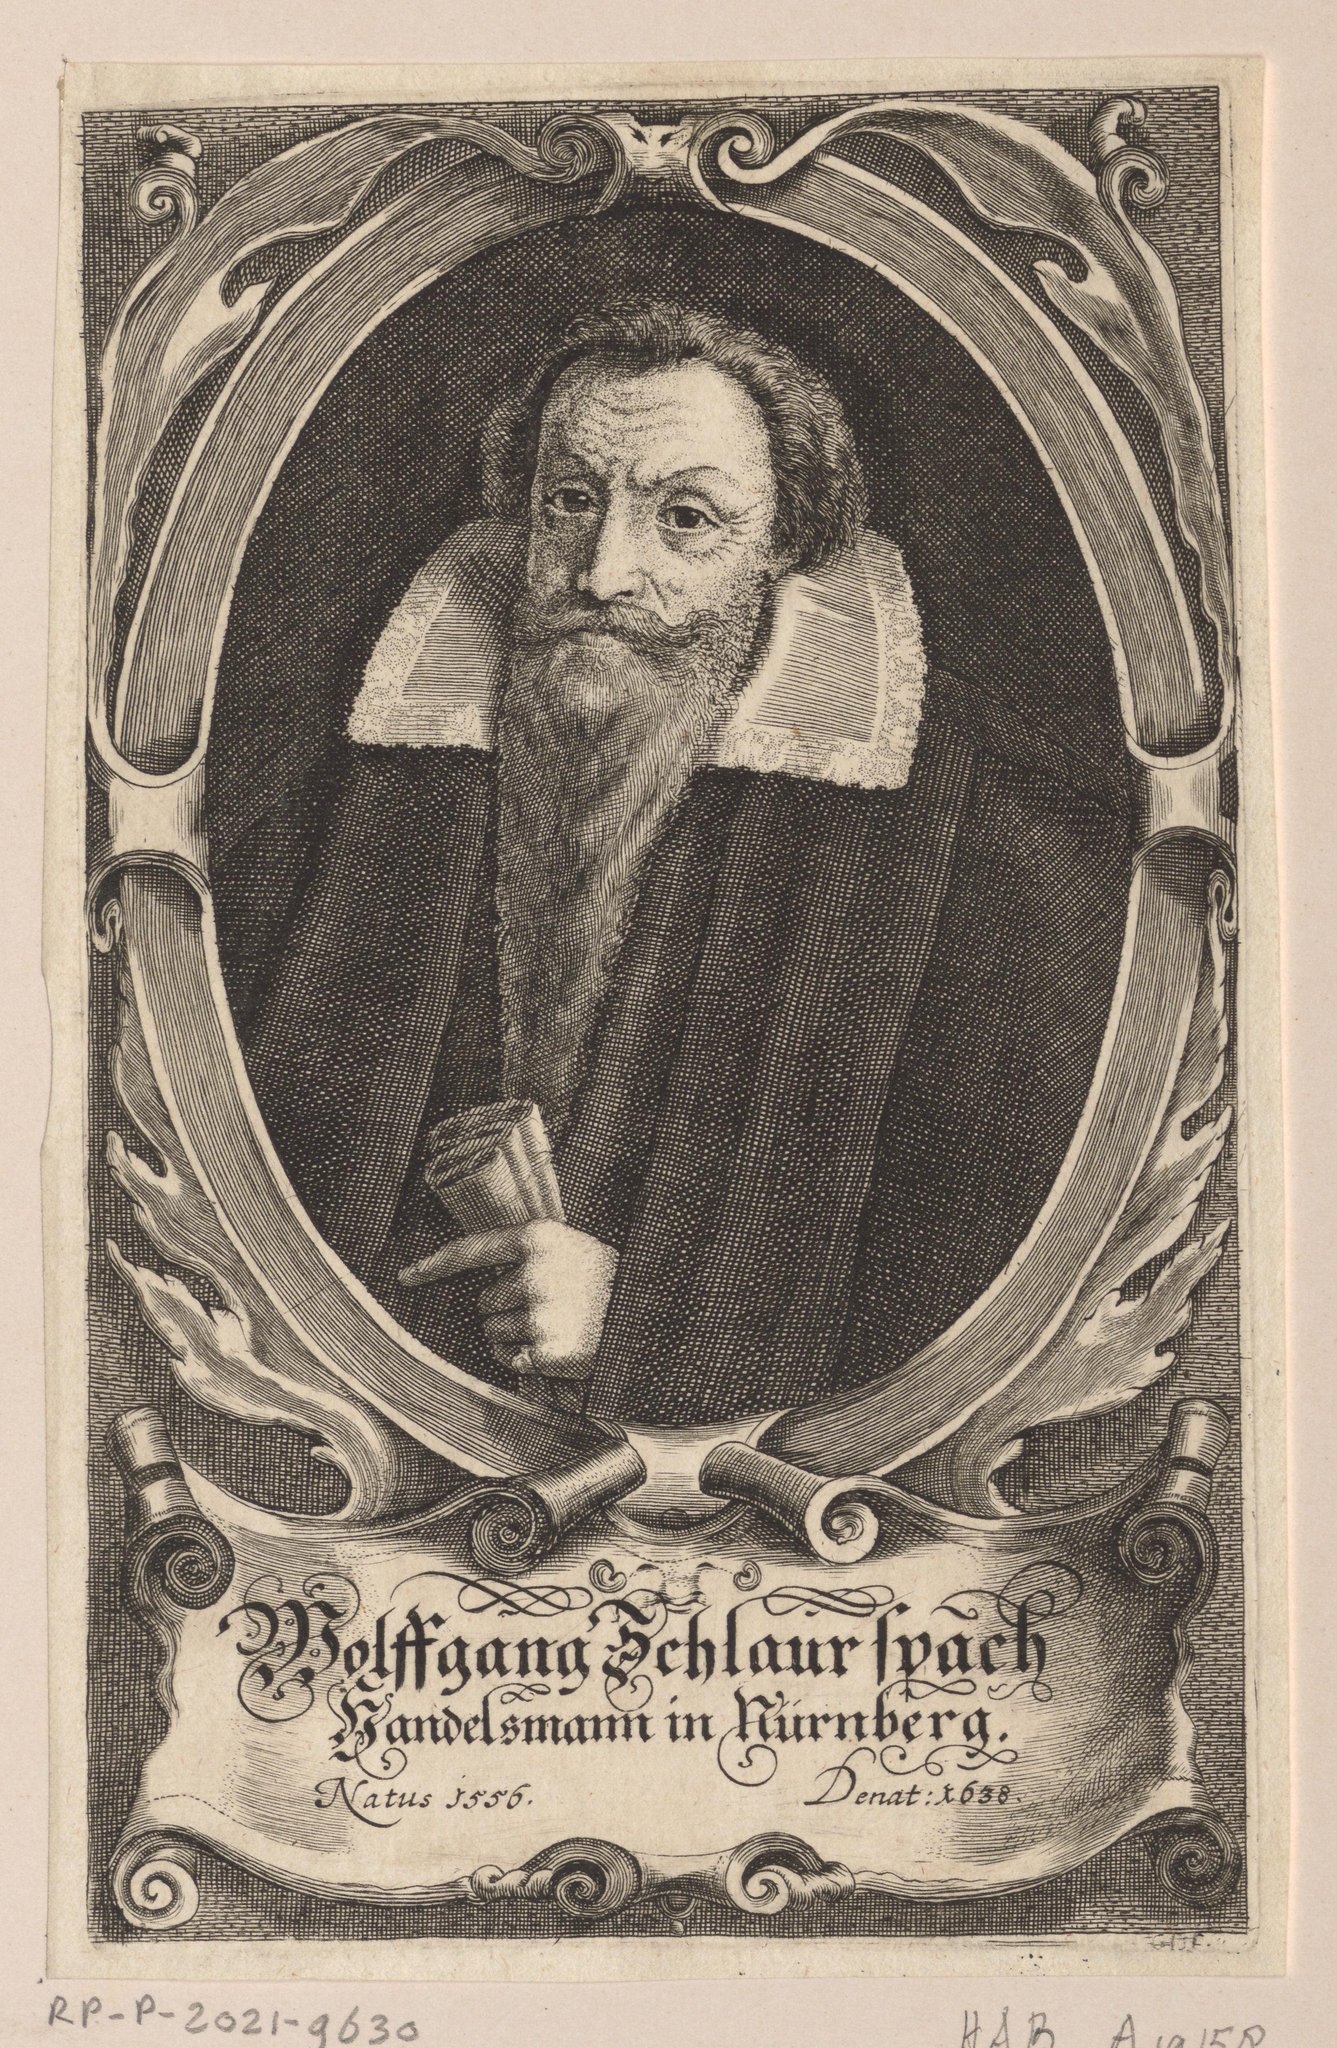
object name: print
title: Portret van Wolfgang Schlaursbach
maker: Anonymous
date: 1638-1699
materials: paper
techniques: engraving, etching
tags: historical persons, merchant, salesman